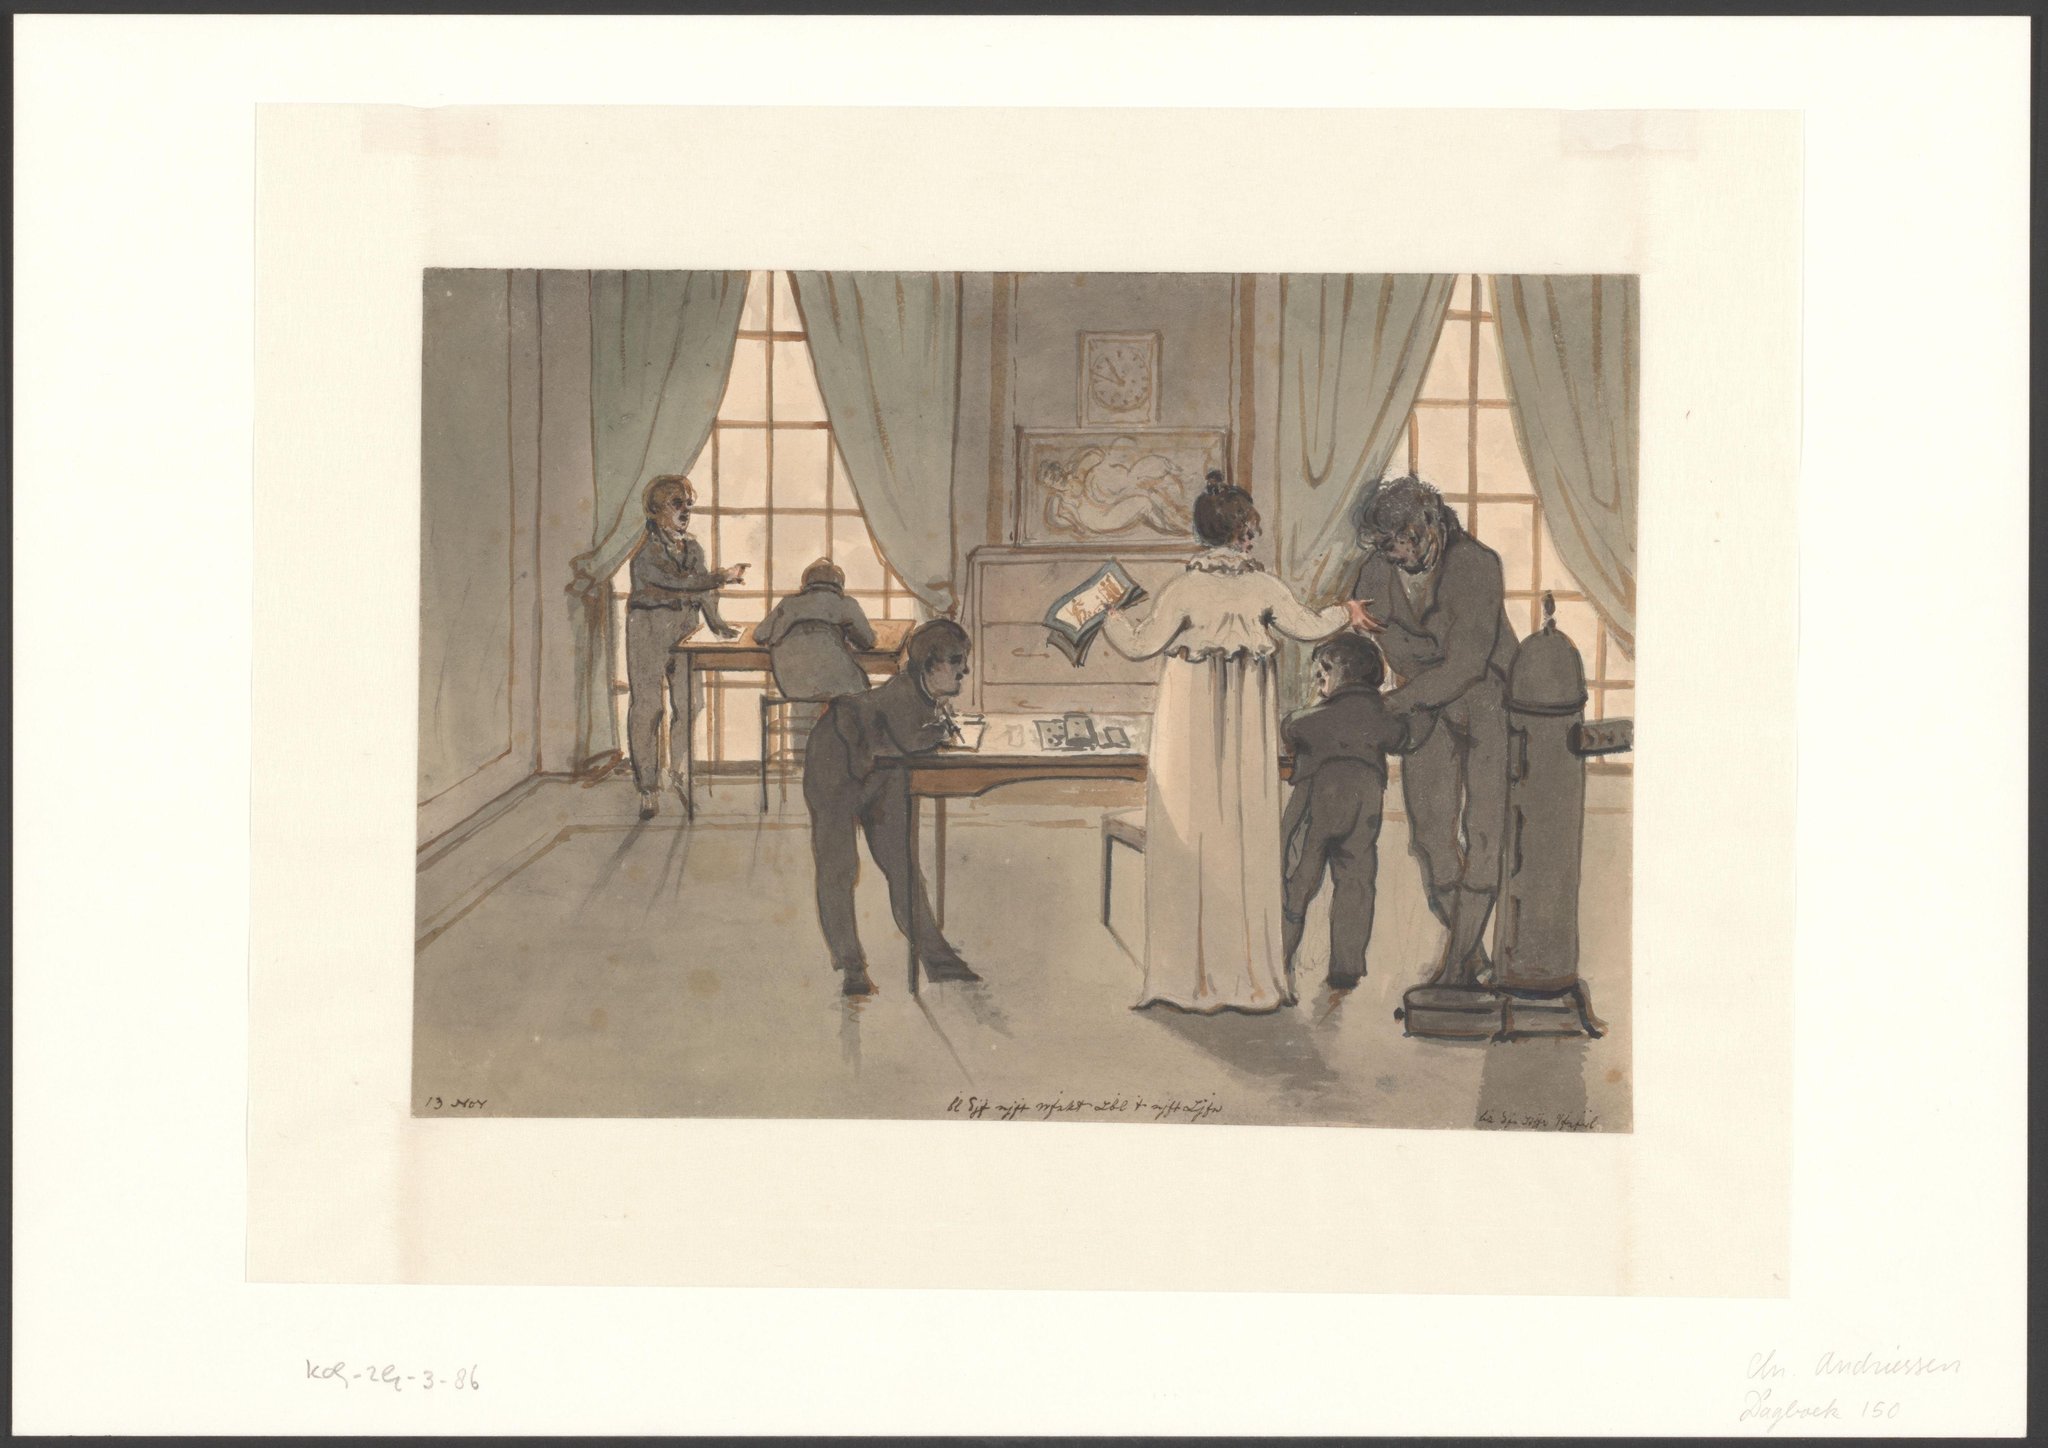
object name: drawing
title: Kinderen bekijken en tekenen naar prenten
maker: christiaan andriessen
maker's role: draughtsman, print maker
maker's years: 1775-1846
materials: ink, paper, pencil, watercolor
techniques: brush, pen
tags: drawing, printed matter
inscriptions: inscription:, inscription:, collector's mark: Lugt 1641a, collector's mark: Lugt 1641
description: Dagboekblad uit het getekende dagboek dat Christiaan Andriessen bijhield van 1805 tot en met 1808.